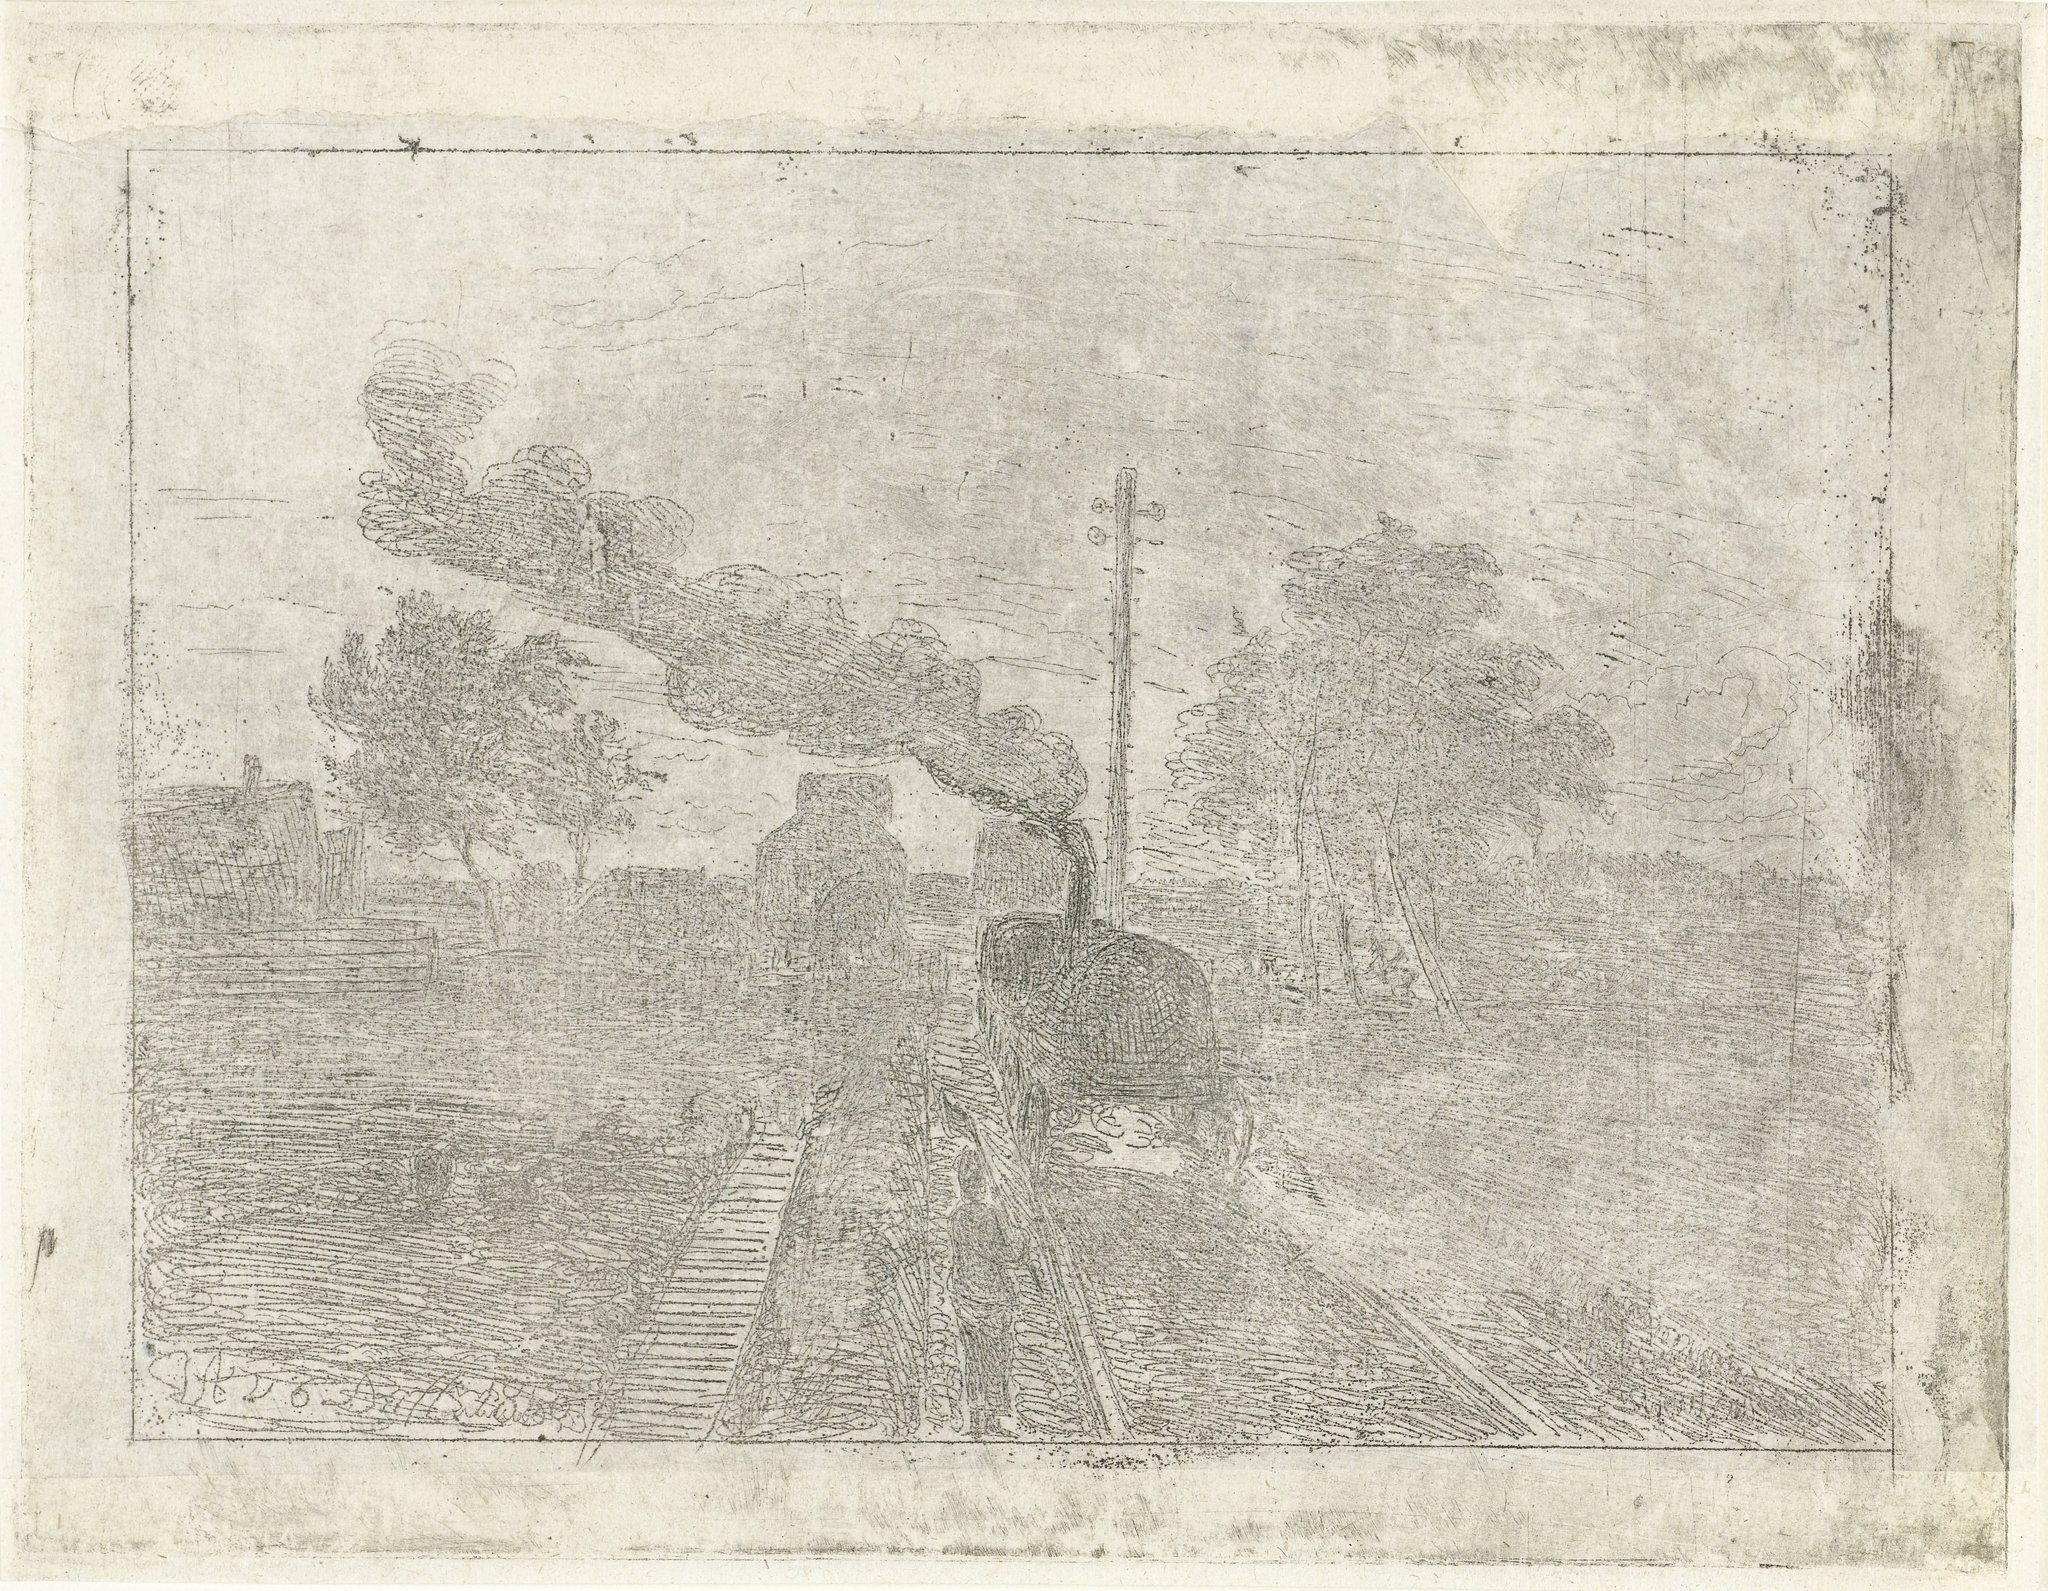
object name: print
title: Landschap met stoomlocomotief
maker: johannes adrianus van der drift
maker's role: print maker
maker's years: 1808-1883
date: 1859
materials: paper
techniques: etching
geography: netherlands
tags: steam locomotive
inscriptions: collector's mark: Lugt 2228